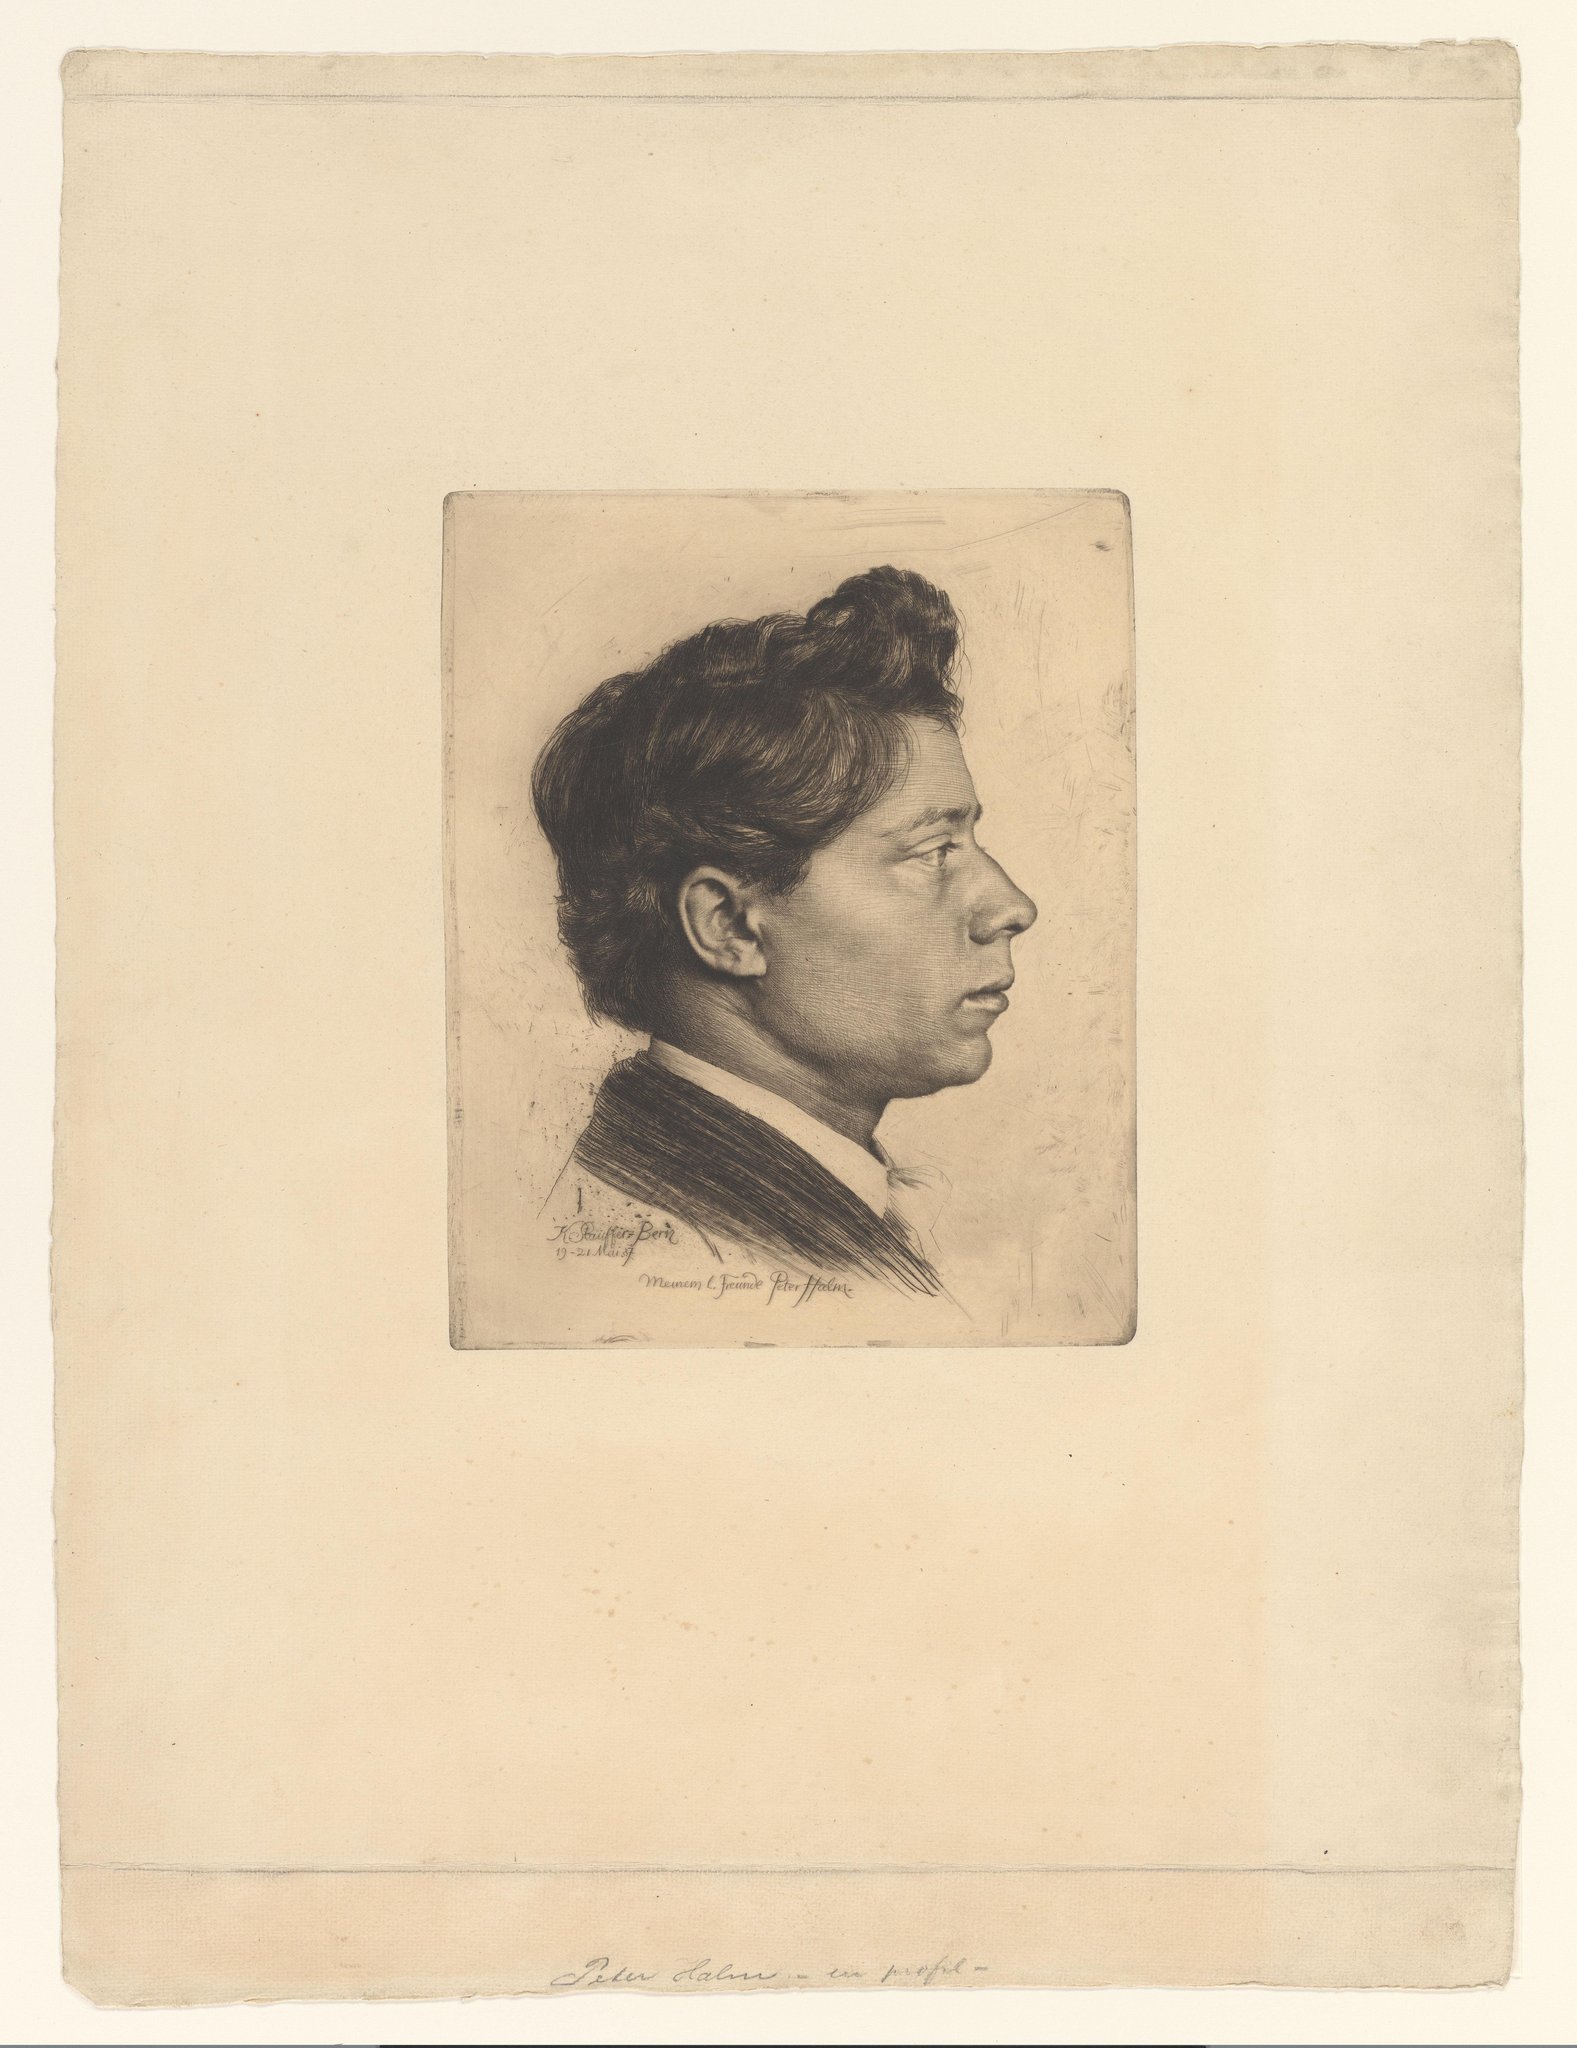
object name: print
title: Portret van Peter von Halm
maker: karl stauffer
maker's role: print maker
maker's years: 1857-1891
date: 1887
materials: paper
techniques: etching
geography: bern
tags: print maker, historical persons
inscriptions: collector's mark: Lugt 2228, collector's mark: Lugt 2113